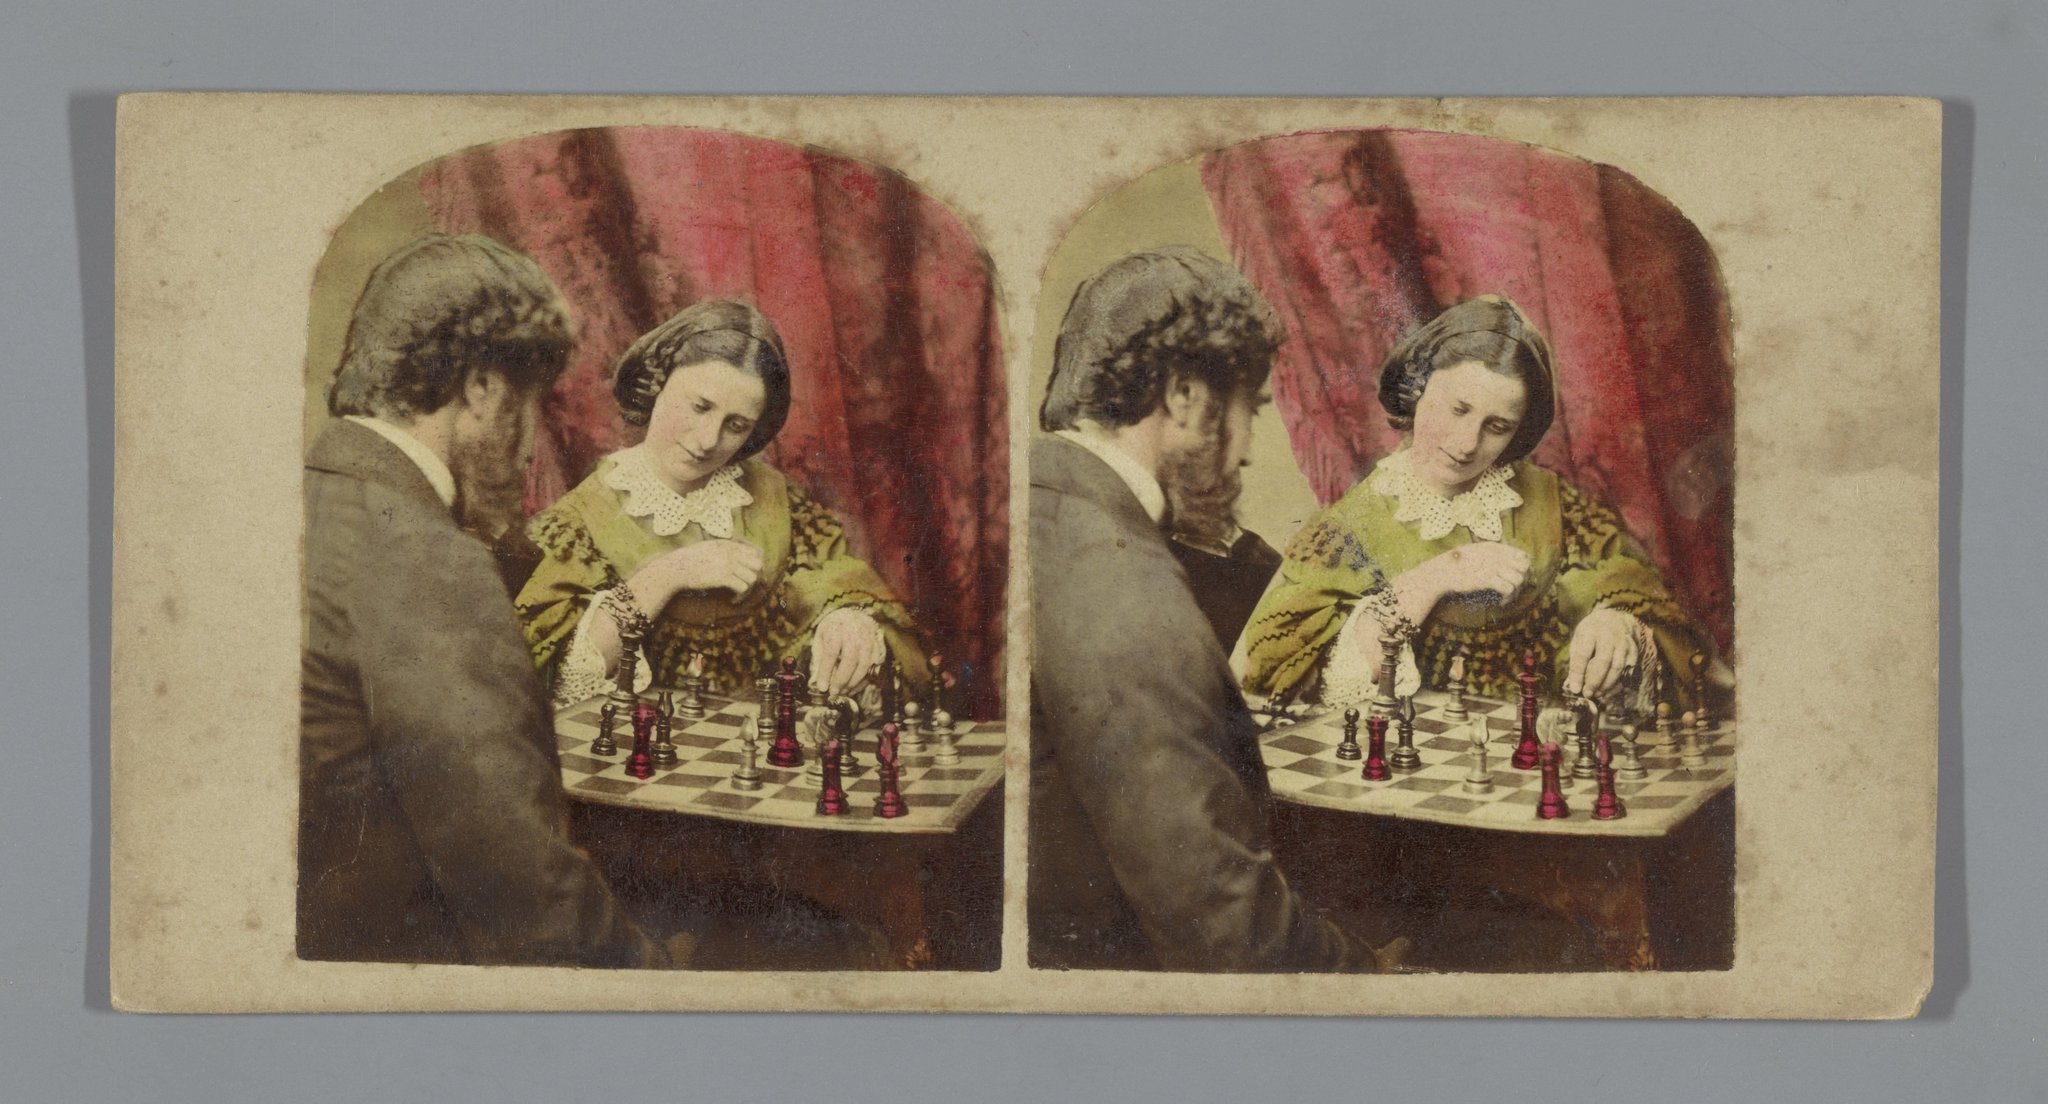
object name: stereograph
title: Man en vrouw spelen schaak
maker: anthony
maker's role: fotograaf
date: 1852-1858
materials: cardboard, paper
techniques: albumen print, hand coloring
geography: pittsburgh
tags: chess